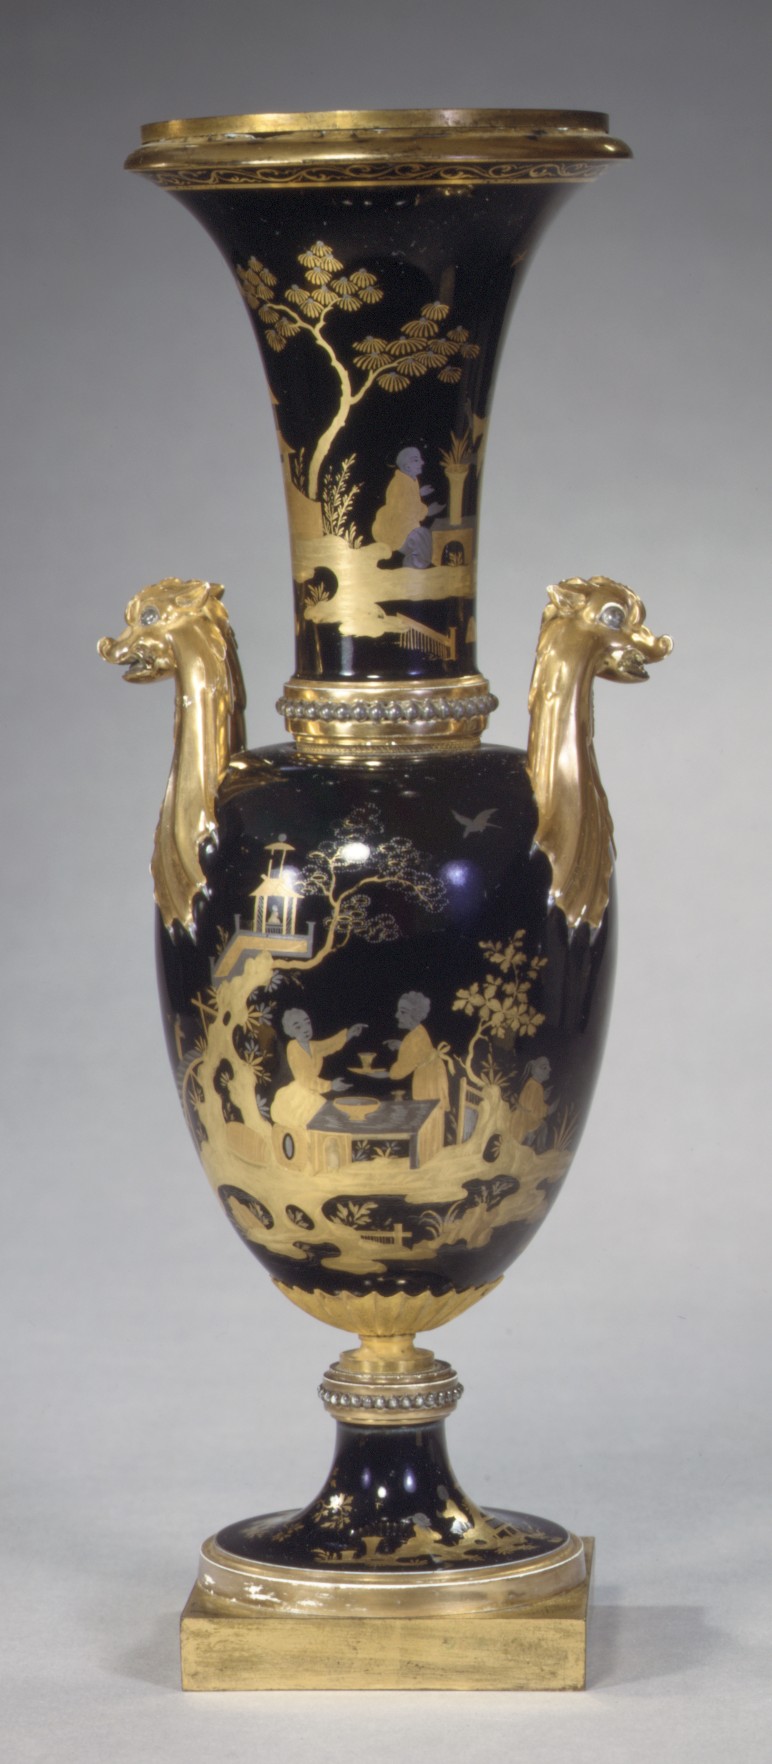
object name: vase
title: Vase (vase chinois) (one of a pair)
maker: sèvres manufactory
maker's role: manufactory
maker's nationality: french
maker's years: 1740-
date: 1791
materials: enamel, gilt, gold, hard paste porcelain, metal, platinum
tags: human figures,chinoiserie